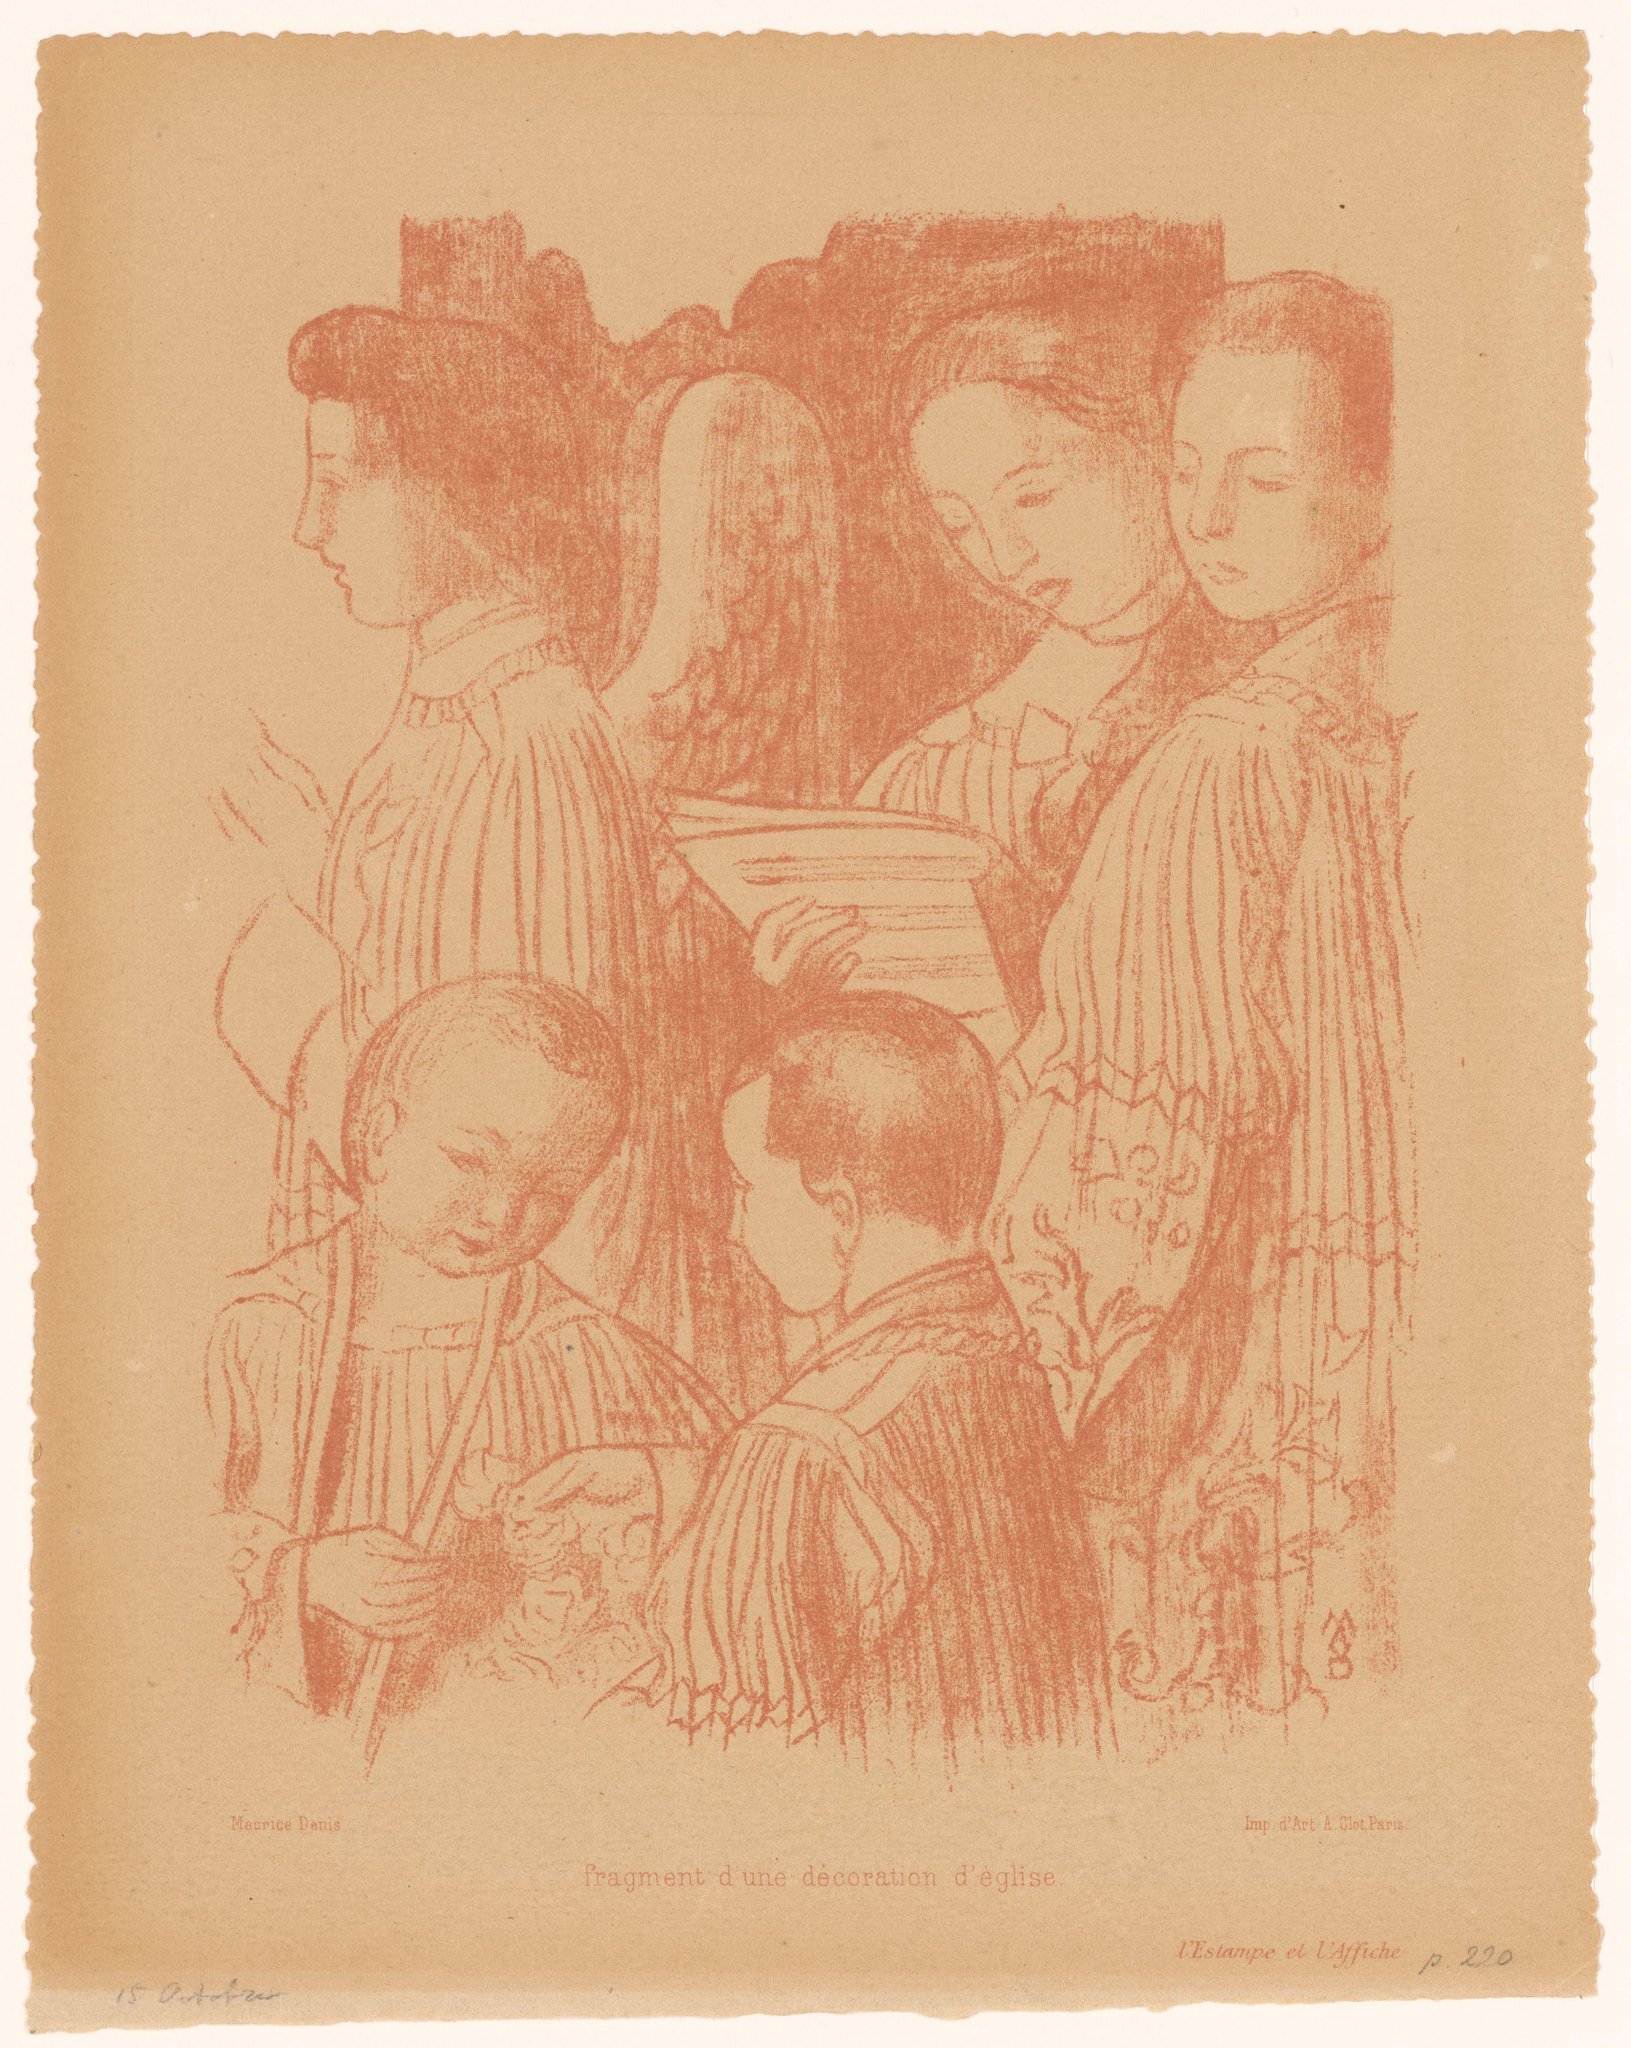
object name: print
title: Drie zingende engelen en twee koorknapen tijdens de Heilige Mis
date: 1899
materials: paper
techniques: lithography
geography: paris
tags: angels singing, making music, choir (in church) (+ angel(s)), holy mass (divine service, especially of roman catholic church)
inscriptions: collector's mark: Lugt 2228a, collector's mark: Lugt 2760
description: Fragment van de decoratie van de Chapelle Sainte-Croix in de Sainte-Marguerite in Vésinet.